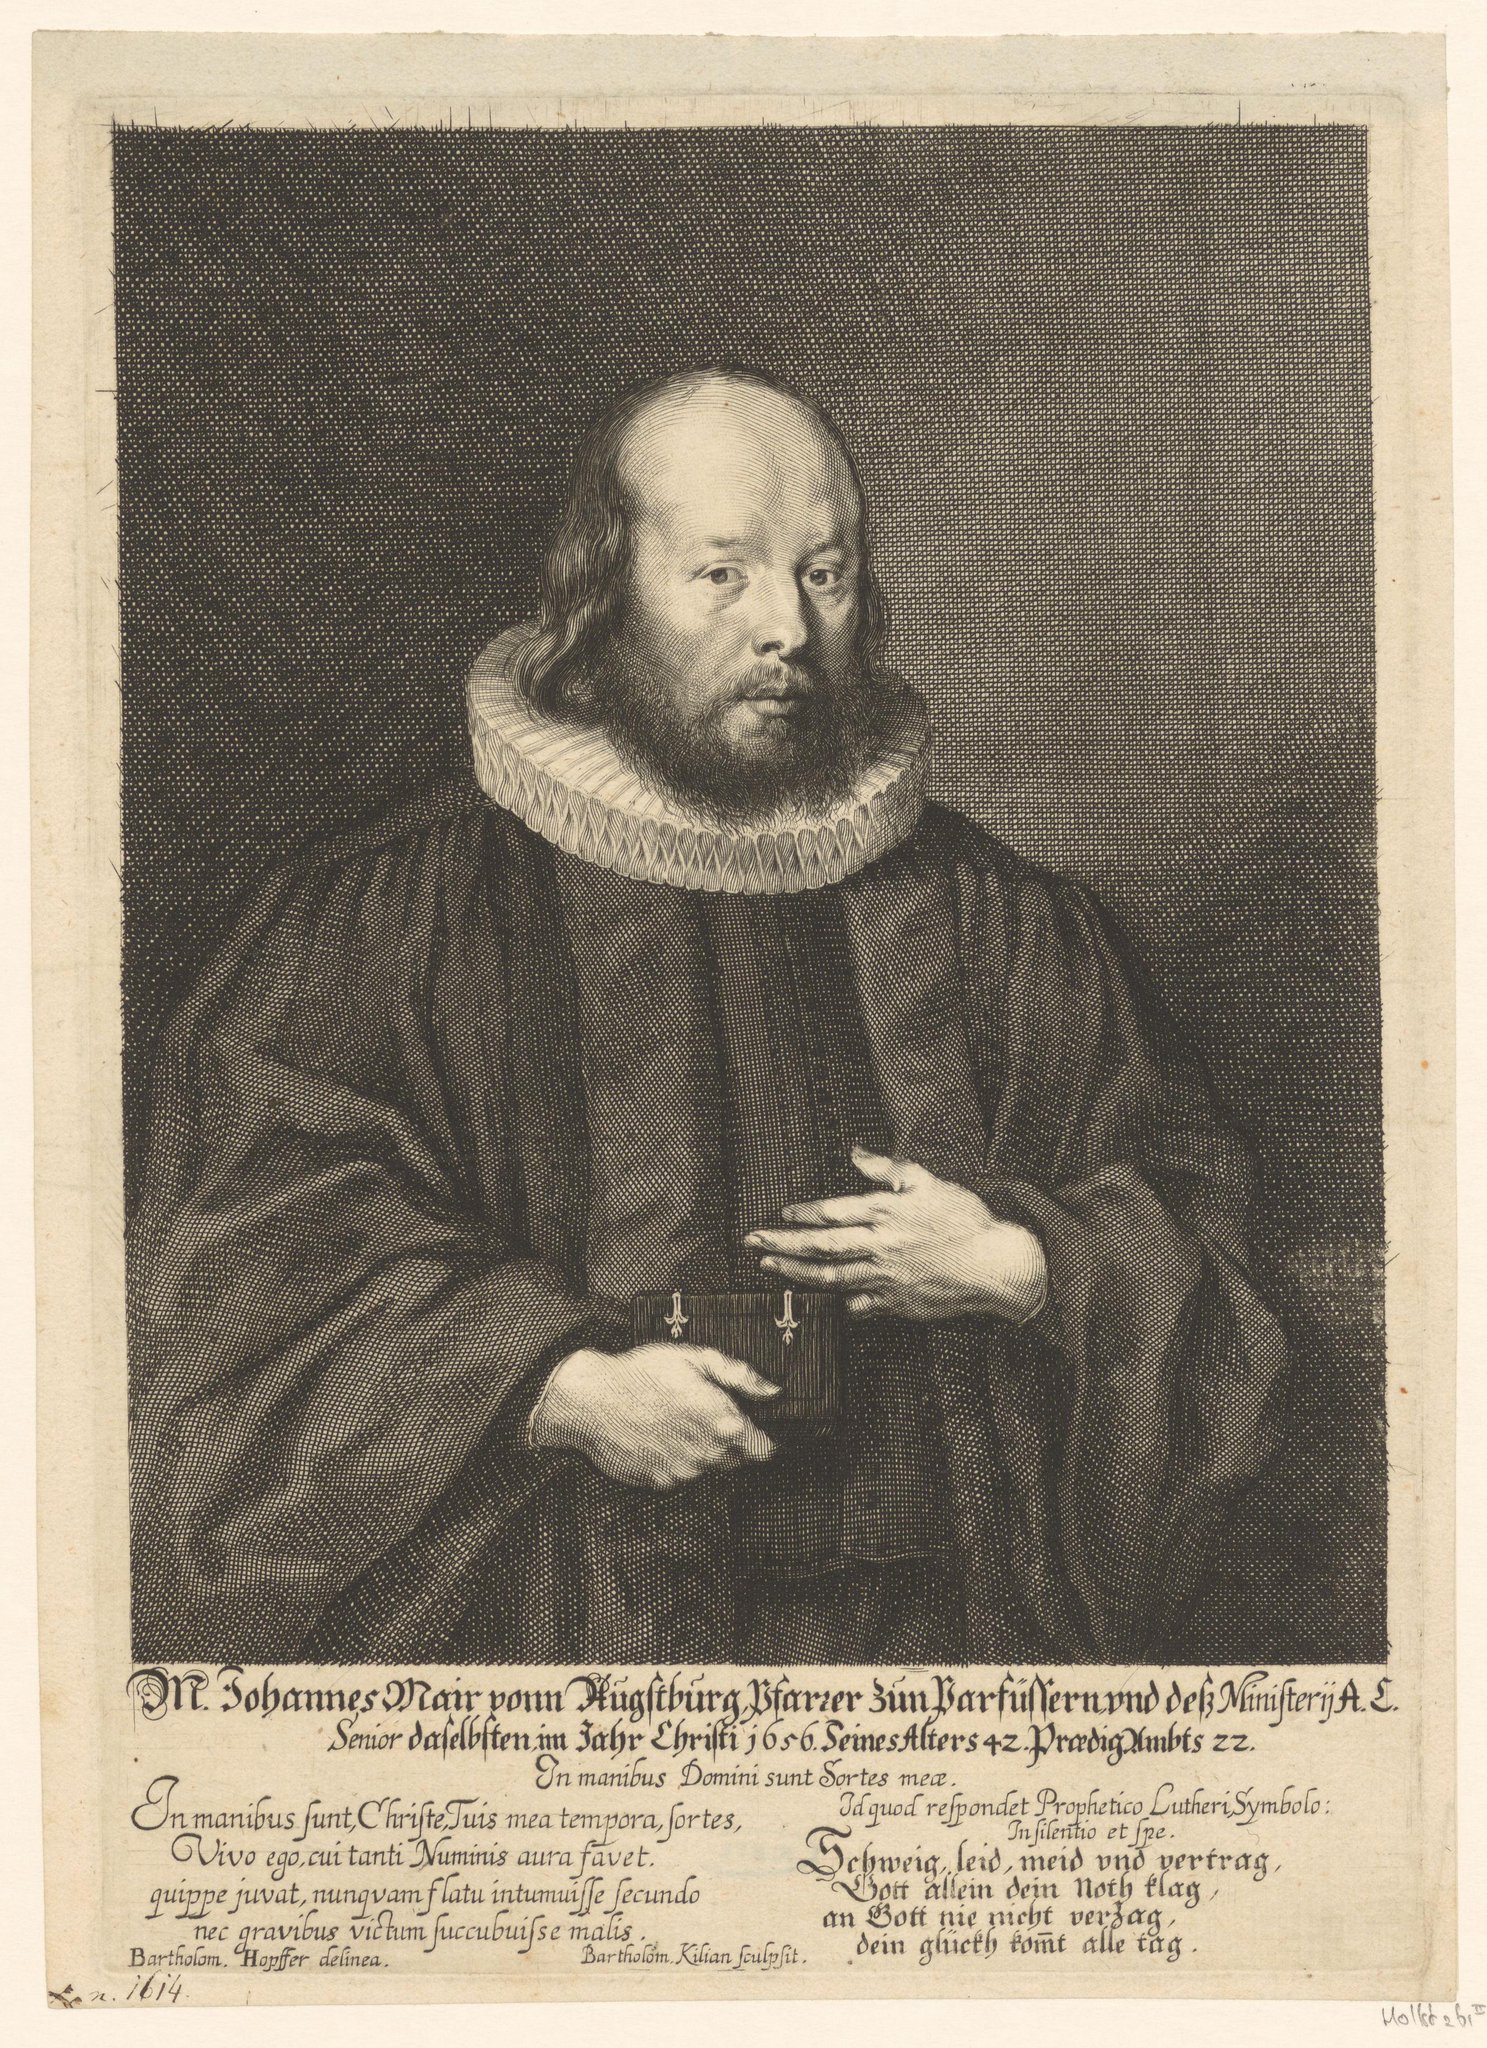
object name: print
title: Portret van Johann Mair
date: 1656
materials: paper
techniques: engraving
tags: johann mair, theologian, historical persons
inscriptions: annotation: ‘n. 1614’, collector's mark: Lugt 2228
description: Tekst in het Latijn en Duits in de marge.